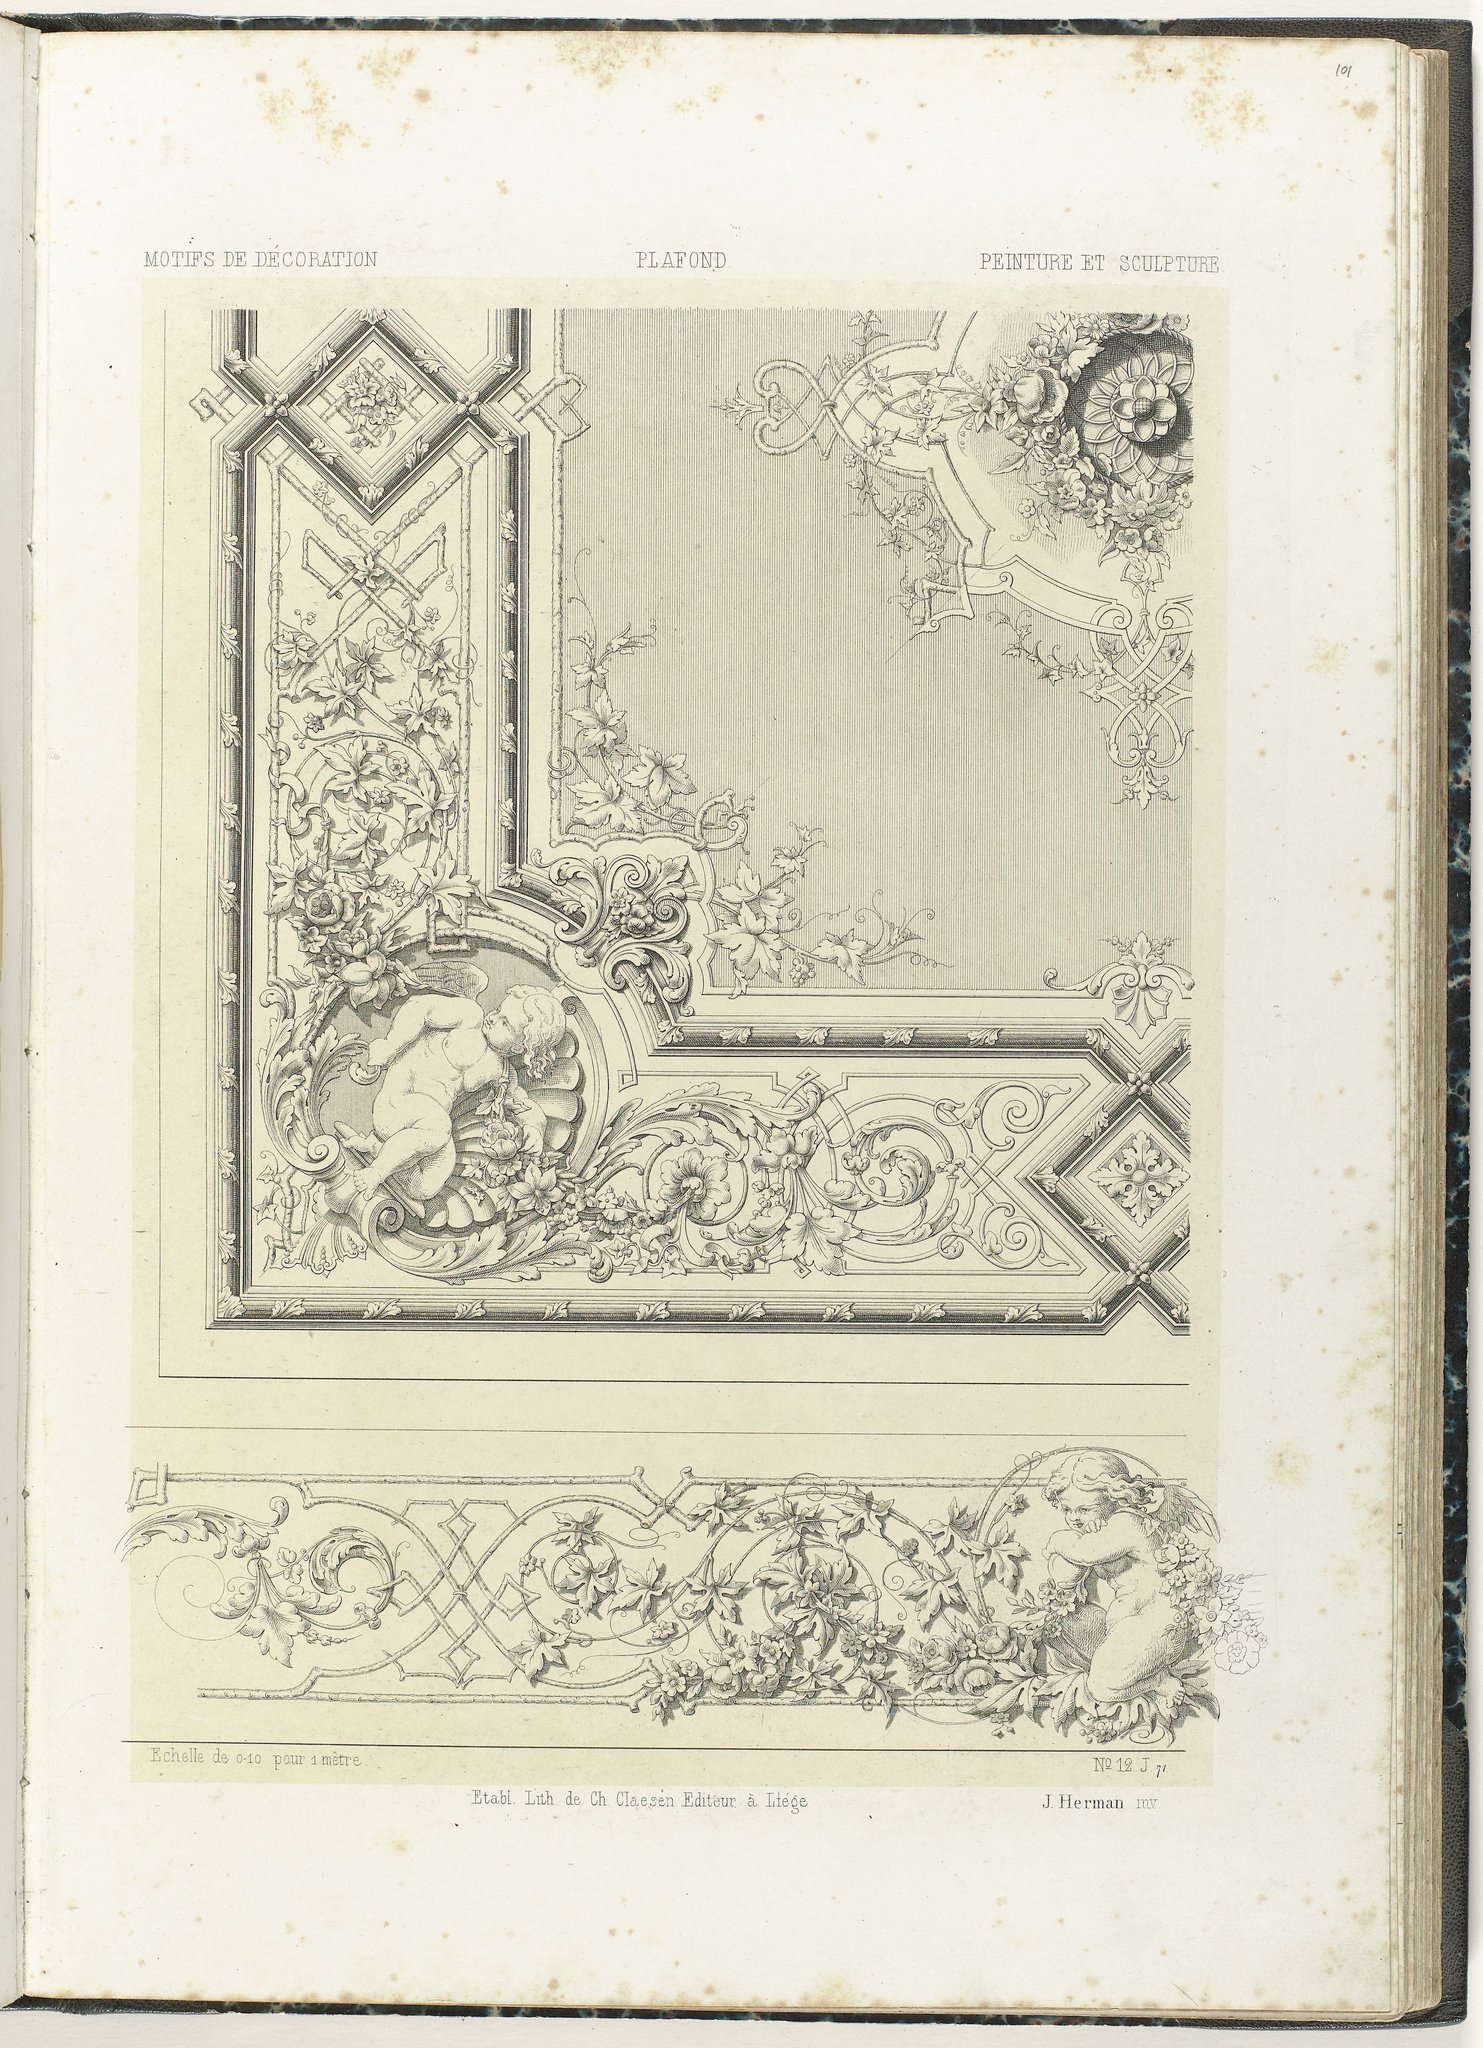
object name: print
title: Plafond en fries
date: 1866-1900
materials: paper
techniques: tone lithography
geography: liège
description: Bovenaan een kwart van een vierkant plafond met in de hoek een putto, onderaan een fries met rechts een putto knielend op bladeren. Linksboven staat vermeld: Motifs de décoration, rechtsboven: Peinture et sculpture, rechtsonder: N° 12. J. 71.